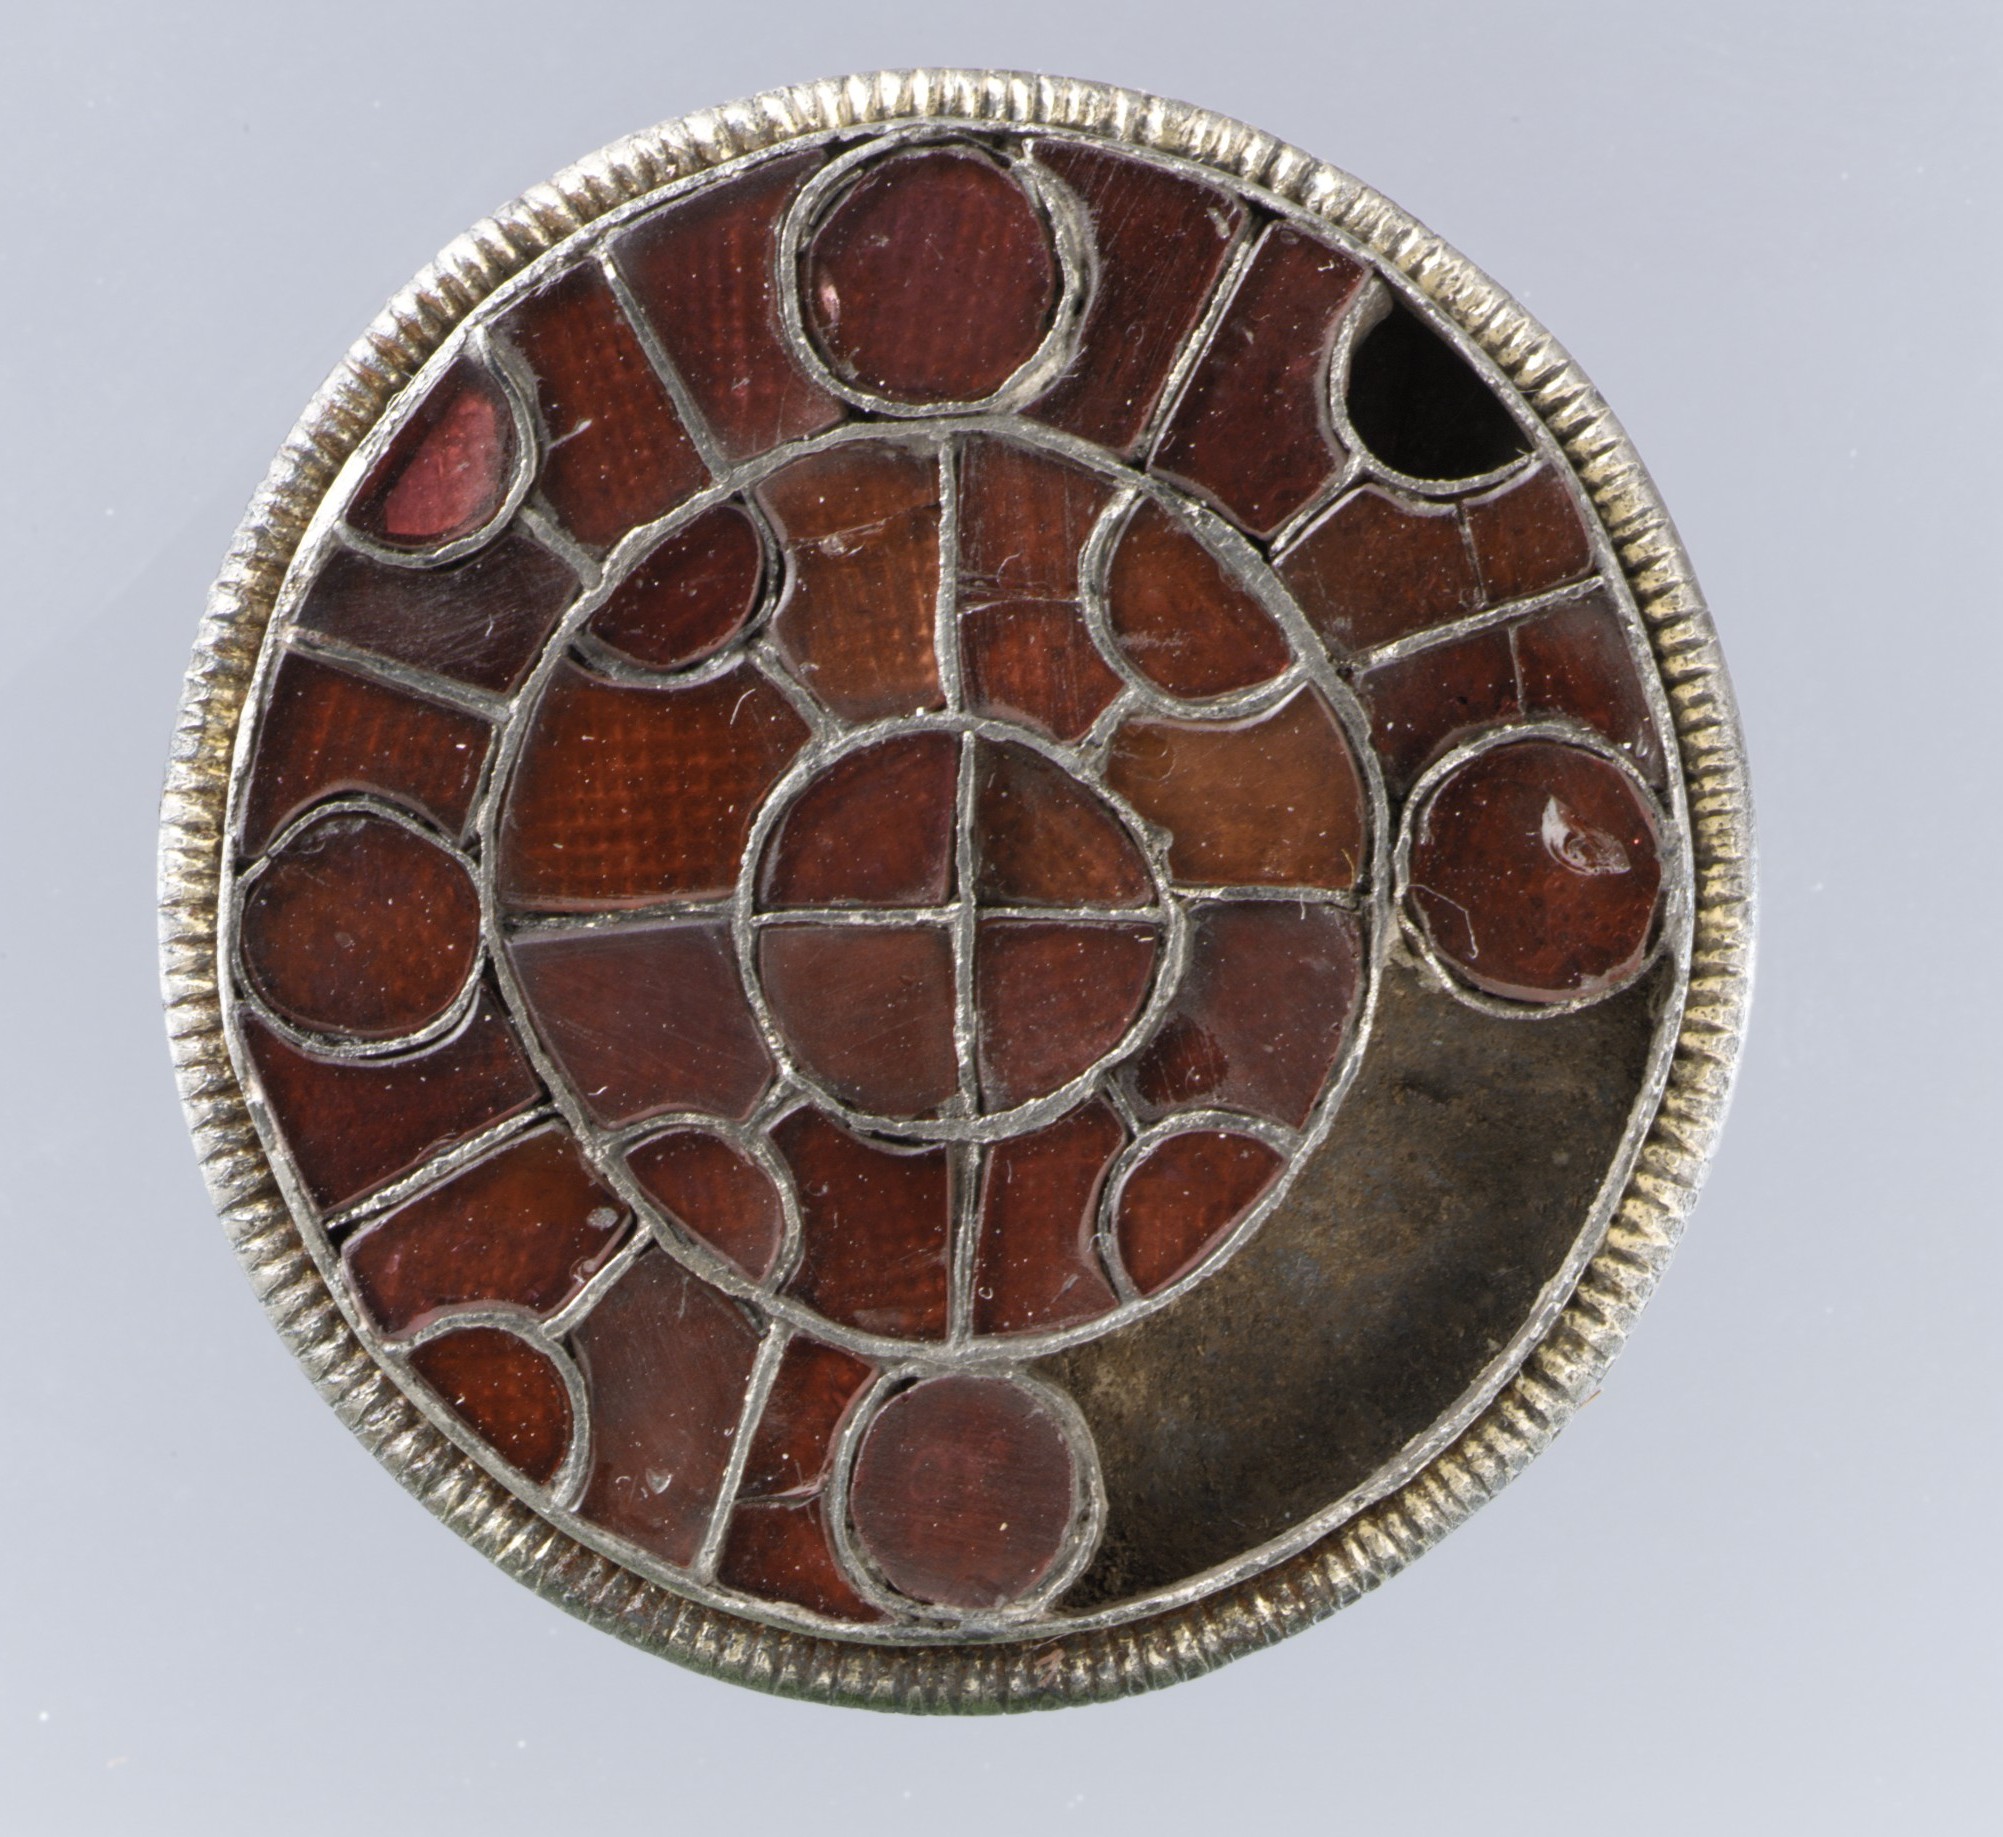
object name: brooch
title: Disk Brooch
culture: frankish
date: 501-550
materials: foil, garnet, silver gilt